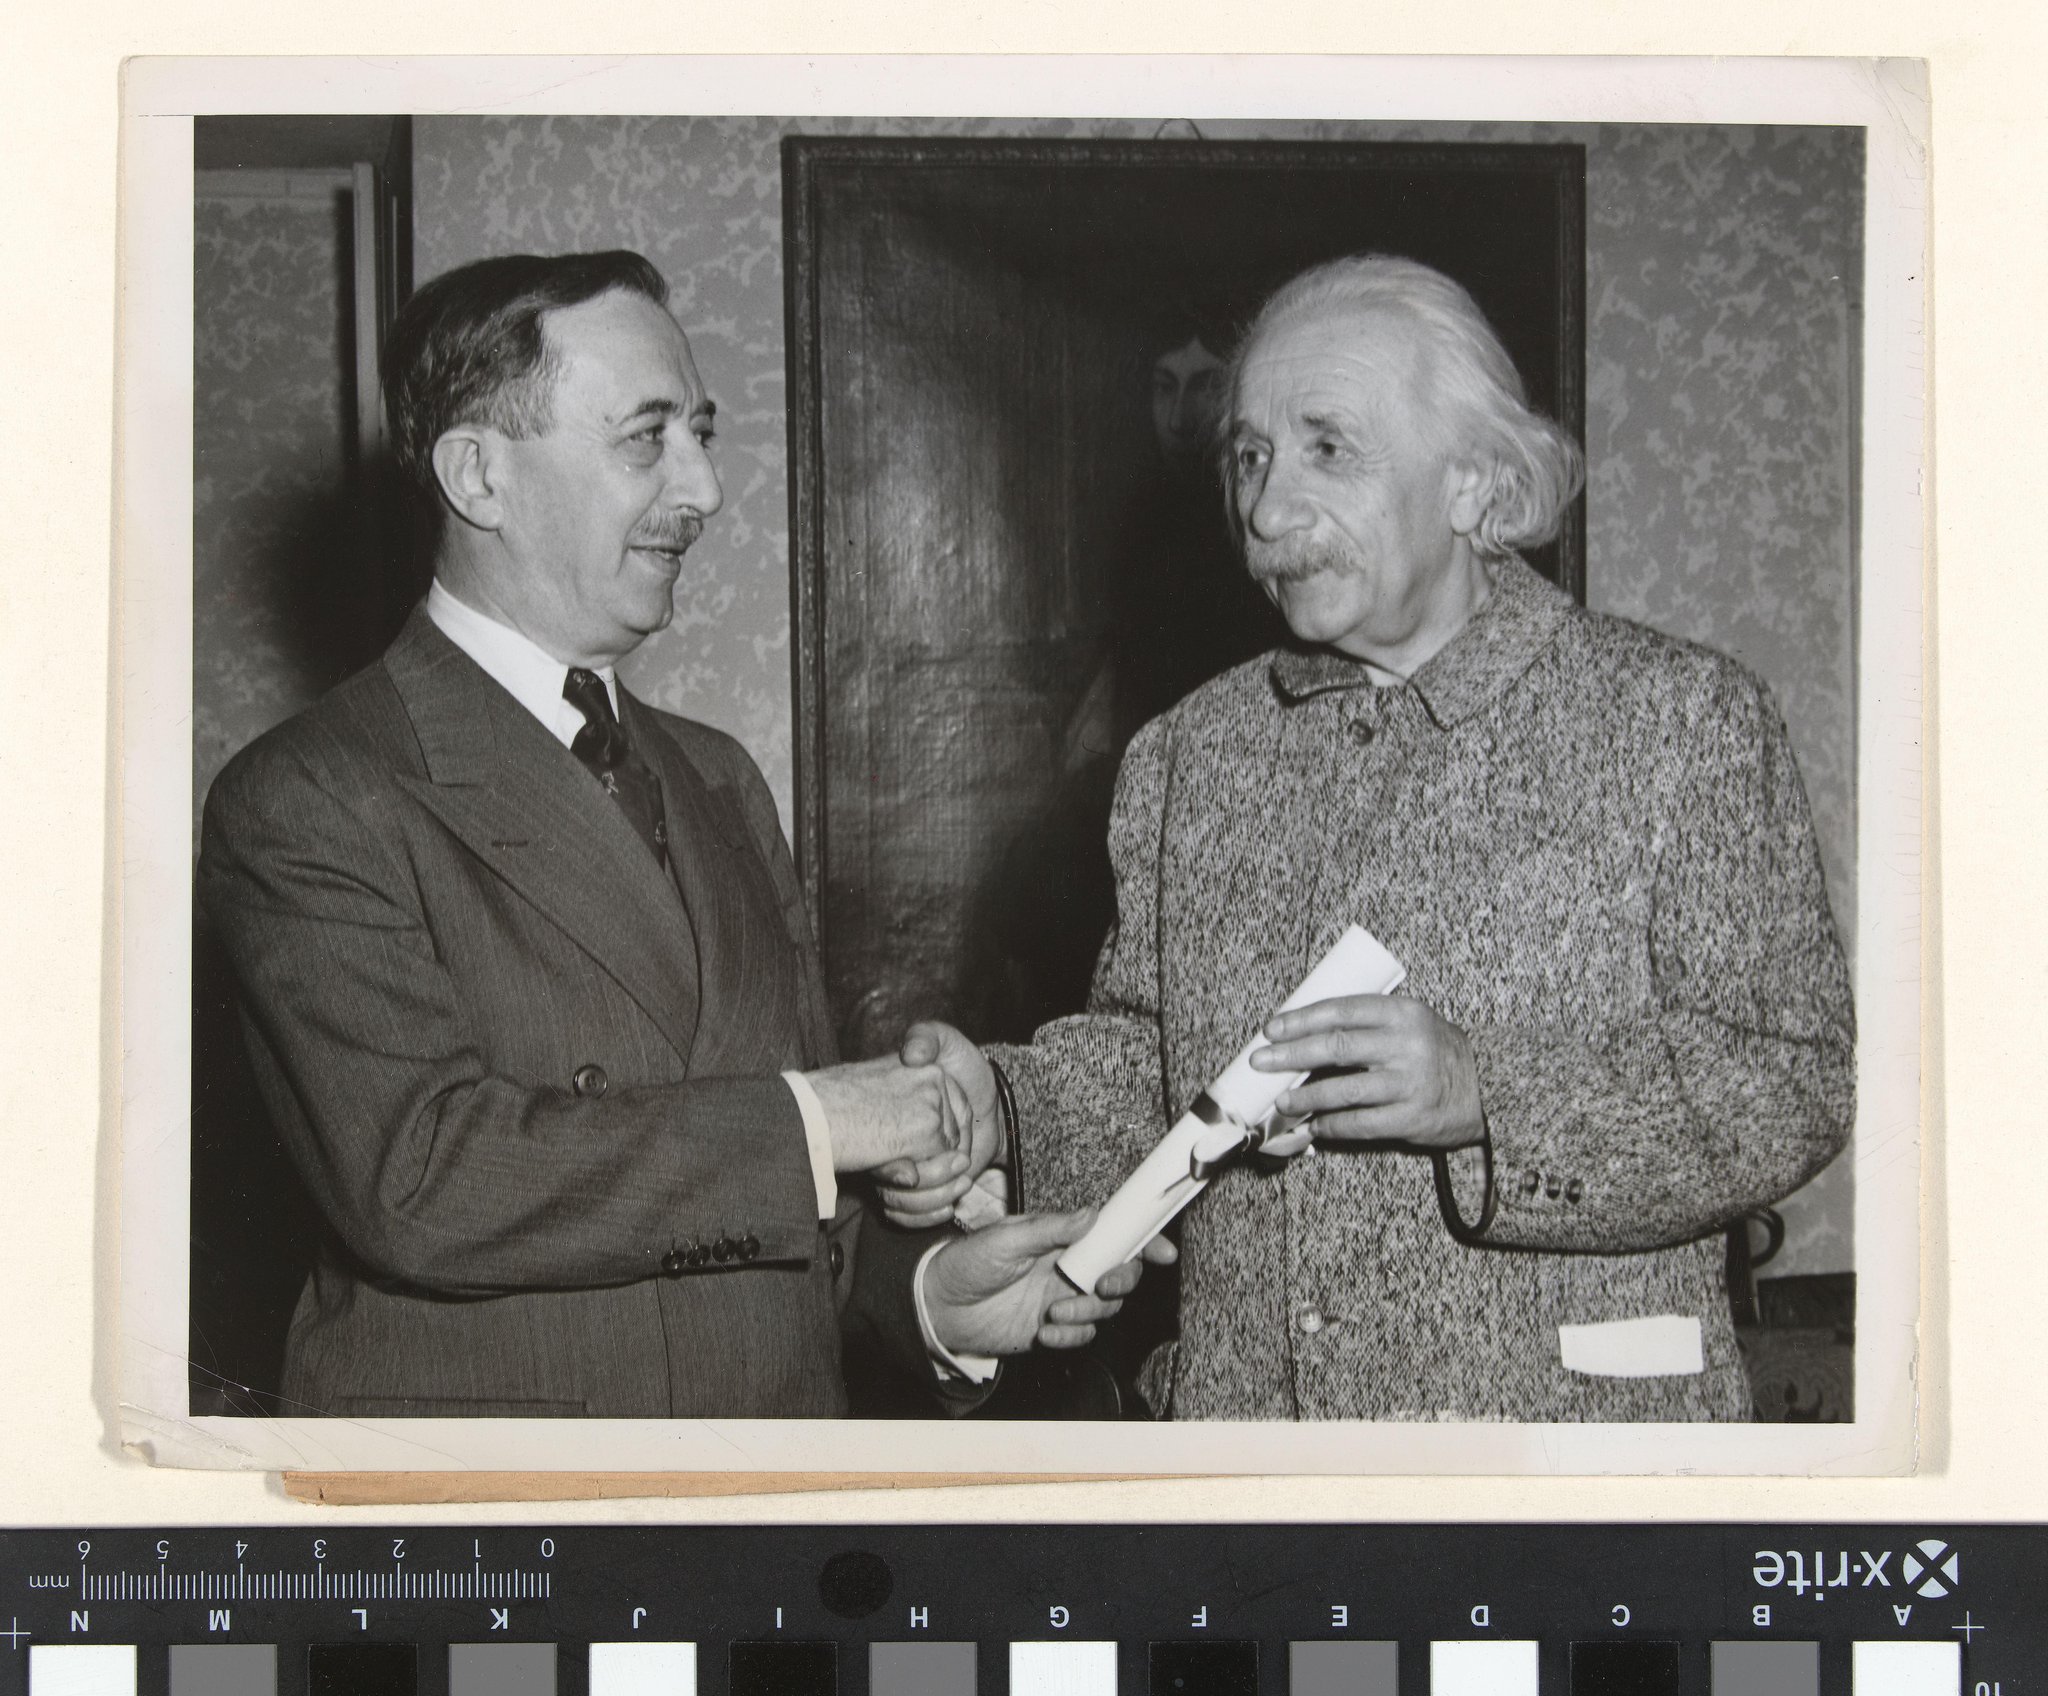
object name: photograph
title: Einstein given Hebrew University Degree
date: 1949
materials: photographic support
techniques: gelatin silver print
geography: new york city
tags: wetenschapper, albert einstein, princeton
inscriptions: stamp: ‘International news photo a unit of king features synd.’